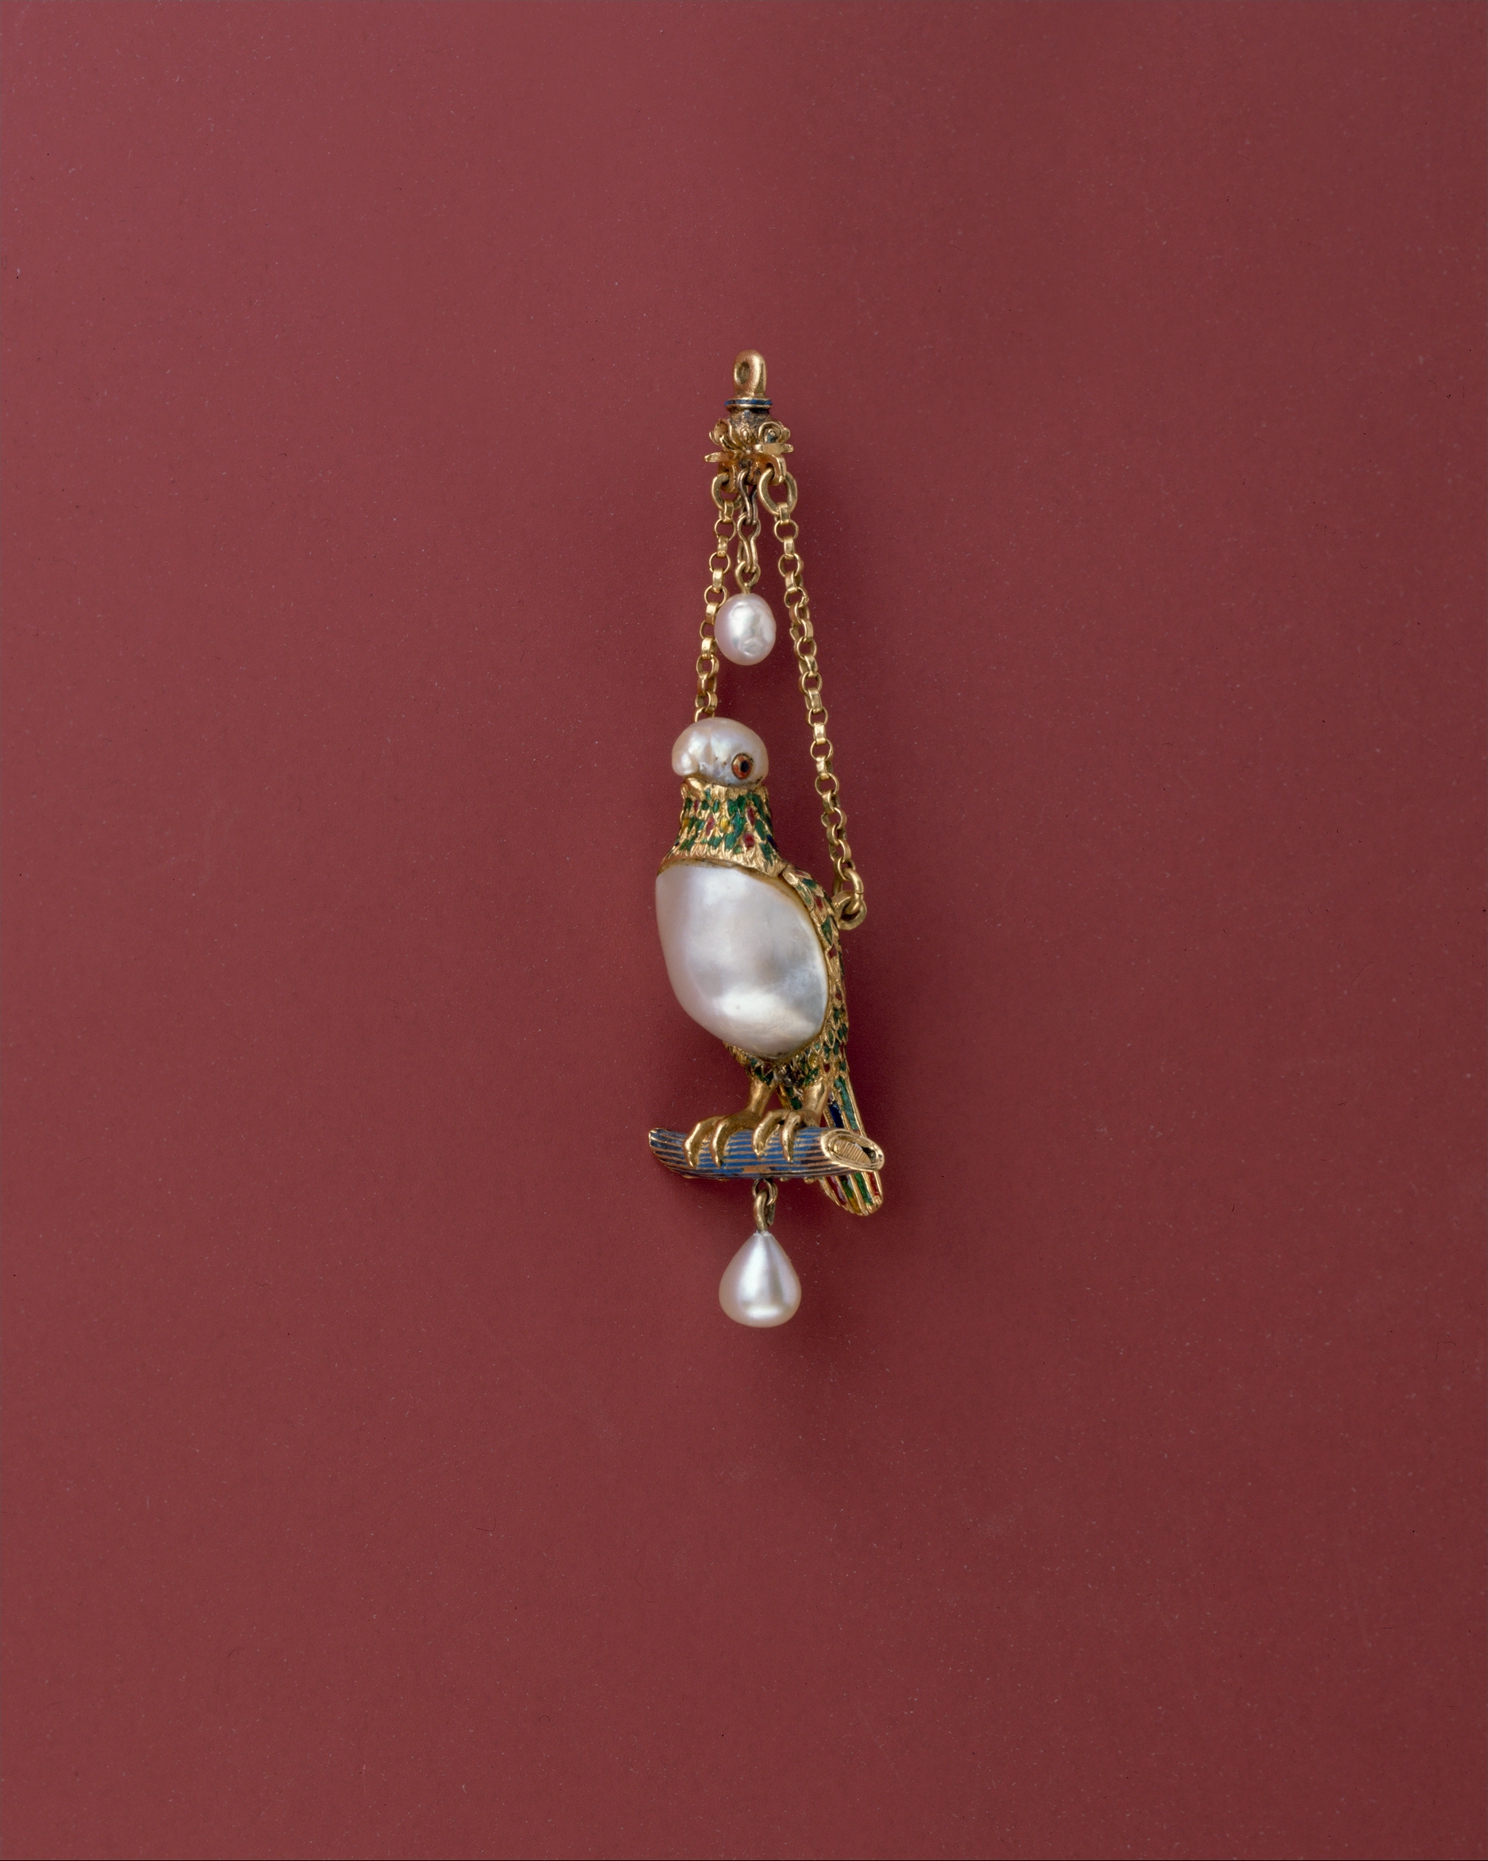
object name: pendant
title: Pendant in the form of a parrot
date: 1567-1633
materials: gold, pearl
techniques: enamel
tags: parrots